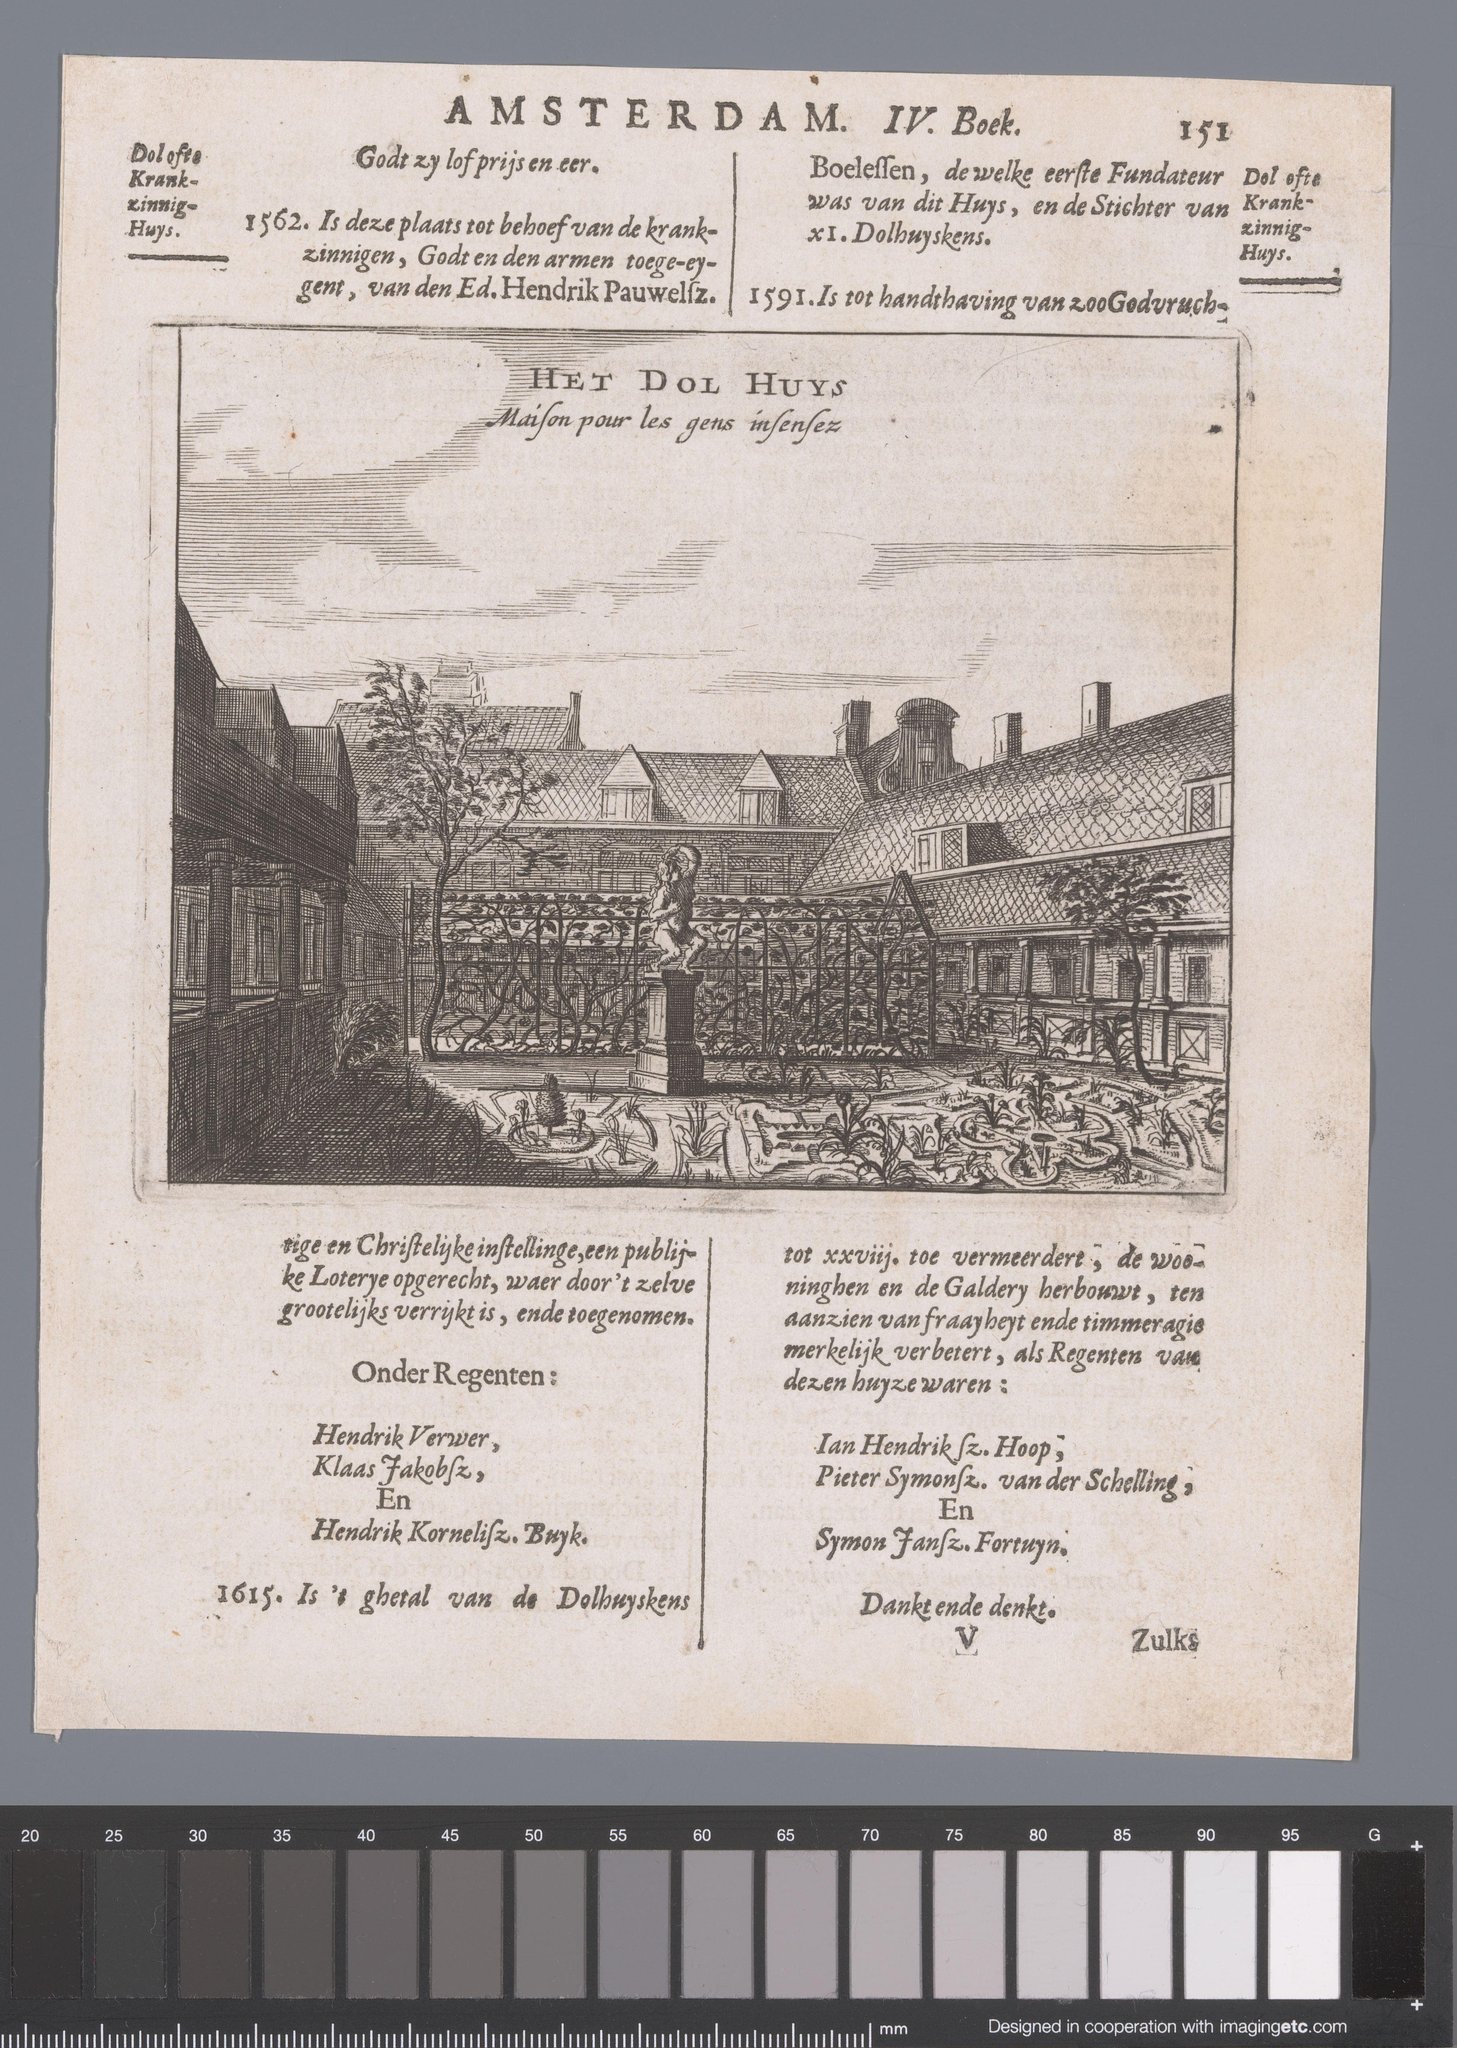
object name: book illustration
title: Het Dol Huys / Maison pour les gens insensez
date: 1665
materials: paper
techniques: etching, letterpress printing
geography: amsterdam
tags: statues, sculptures in garden, dolhuis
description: Prent uit: Domselaer, Tobias van. Beschryvinge van Amsterdam, haar eerste oorspronk uyt den huyze der heeren van Aemstel en Aemstellant: met een verhaal van haar leven en dappere krijgsdaden. Amsterdams kleyne beginselen, outheyt, bemuuring, en verscheyde vergrotingen (...). Amsterdam: Marcus Willemsz. Doornick, 1665, p. 151.